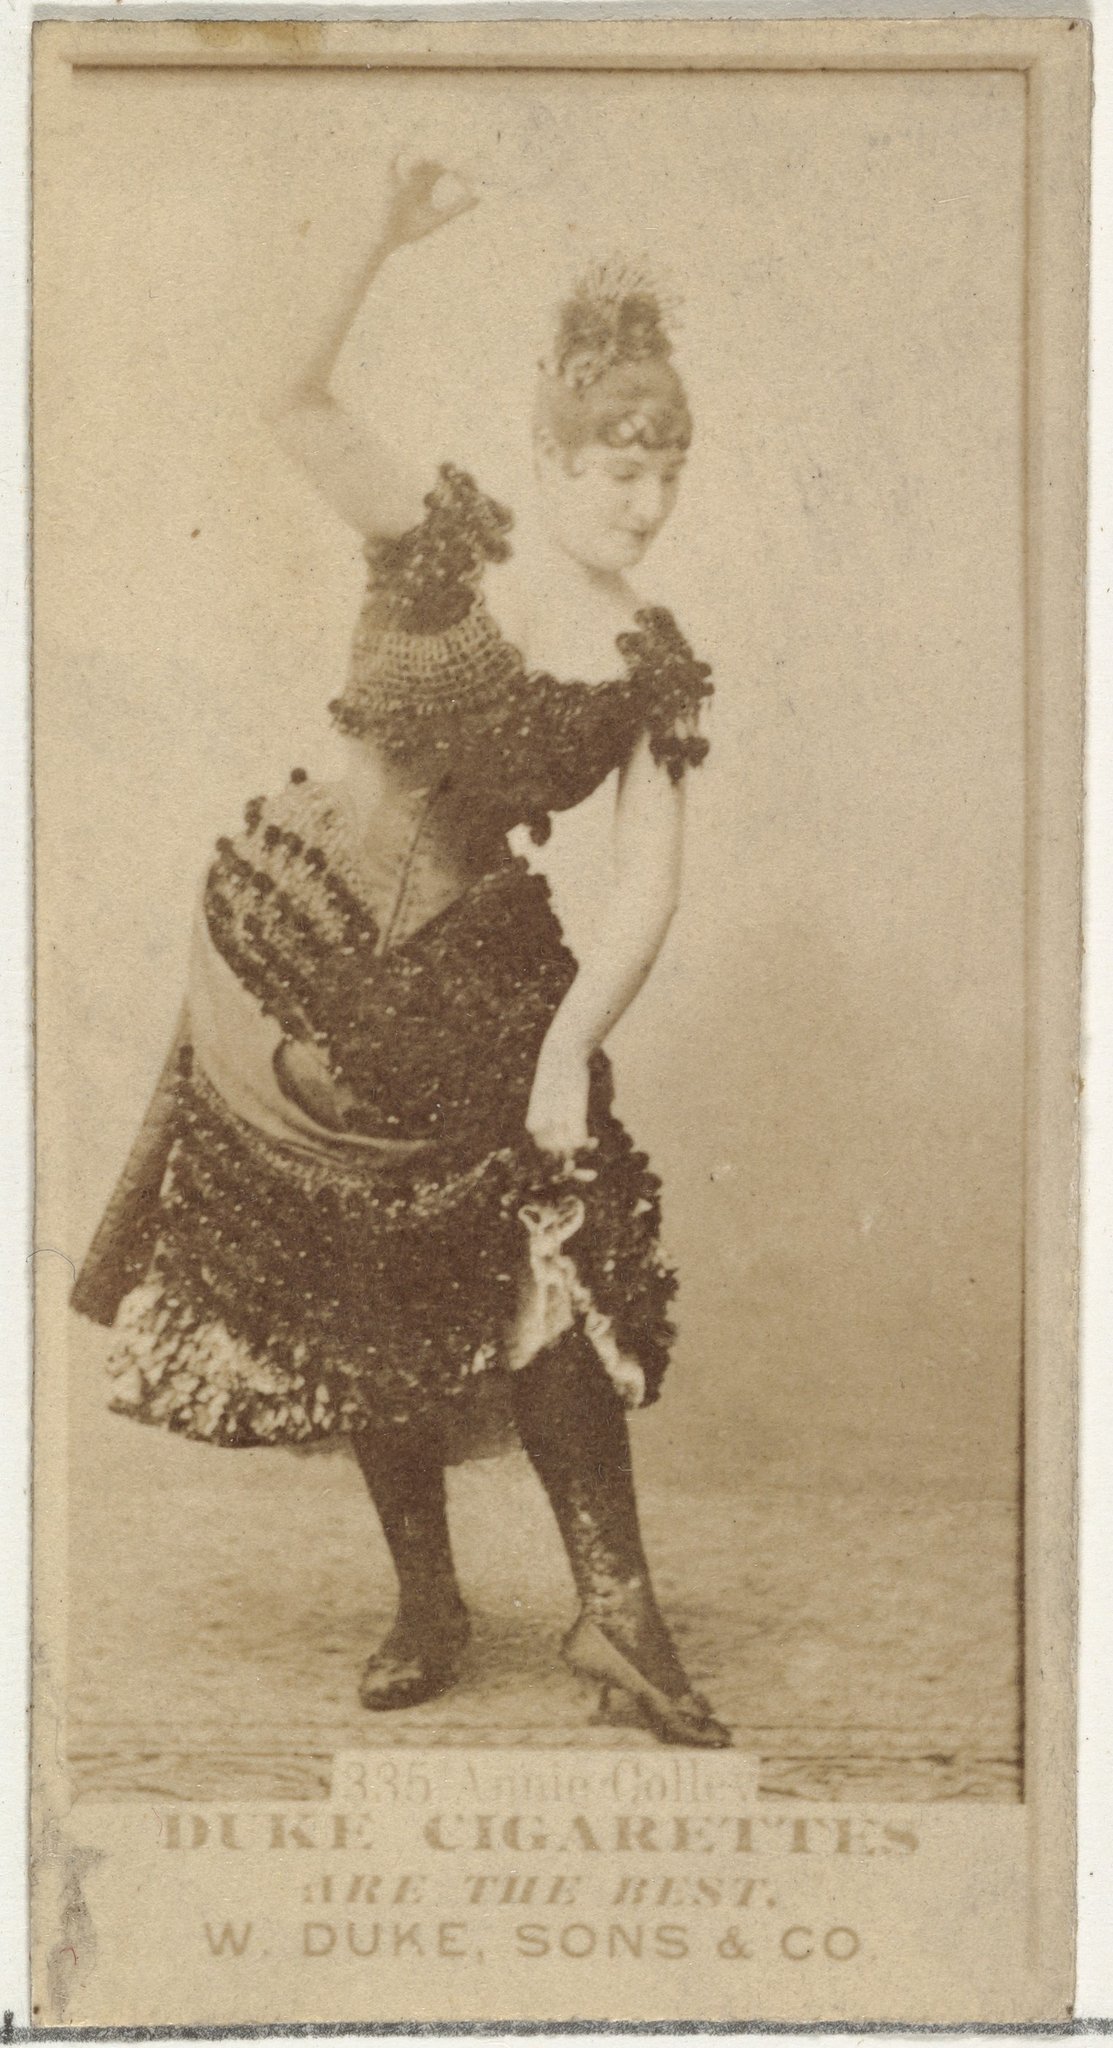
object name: photograph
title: Card Number 335, Annie Colley, from the Actors and Actresses series (N145-7) issued by Duke Sons & Co. to promote Duke Cigarettes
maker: w. duke, sons & co.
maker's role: publisher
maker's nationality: american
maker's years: 1870-1920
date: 1880-1889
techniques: albumen silver print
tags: portraits,women,actresses